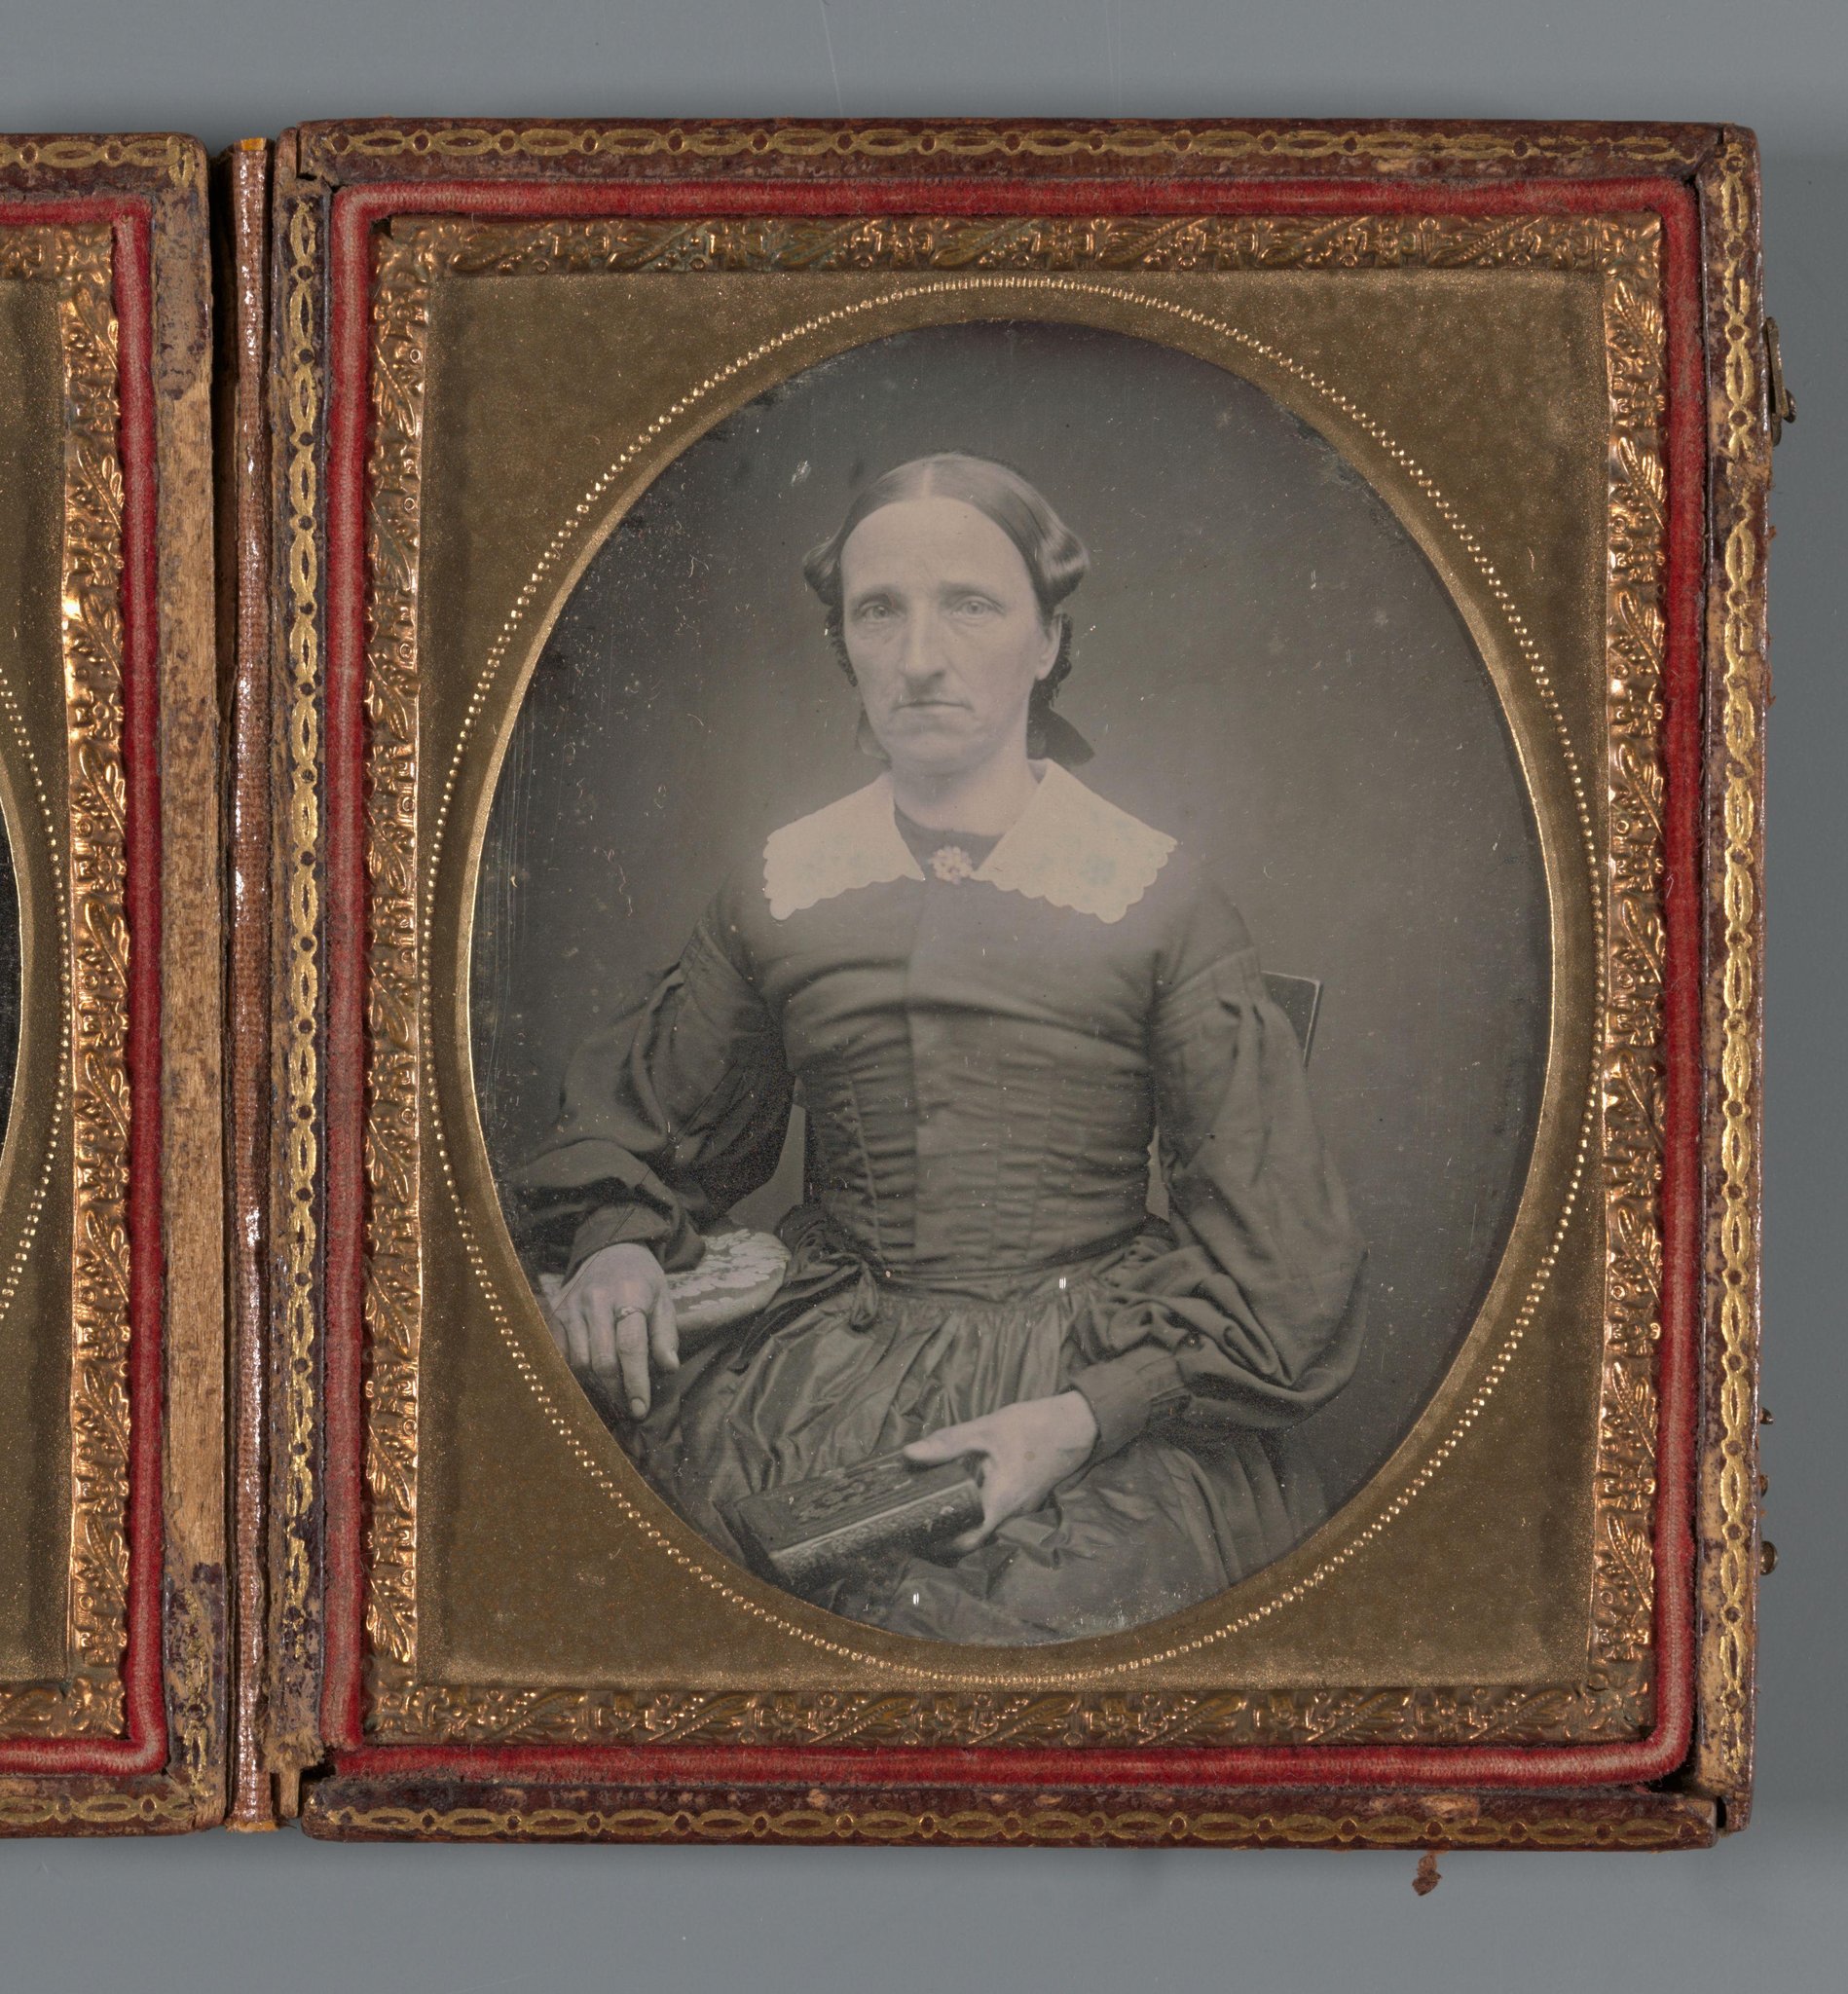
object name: photograph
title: Portret van een onbekende vrouw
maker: Anonymous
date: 1857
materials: copper, glass, leather, velvet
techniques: daguerreotype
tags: adult woman, historical persons